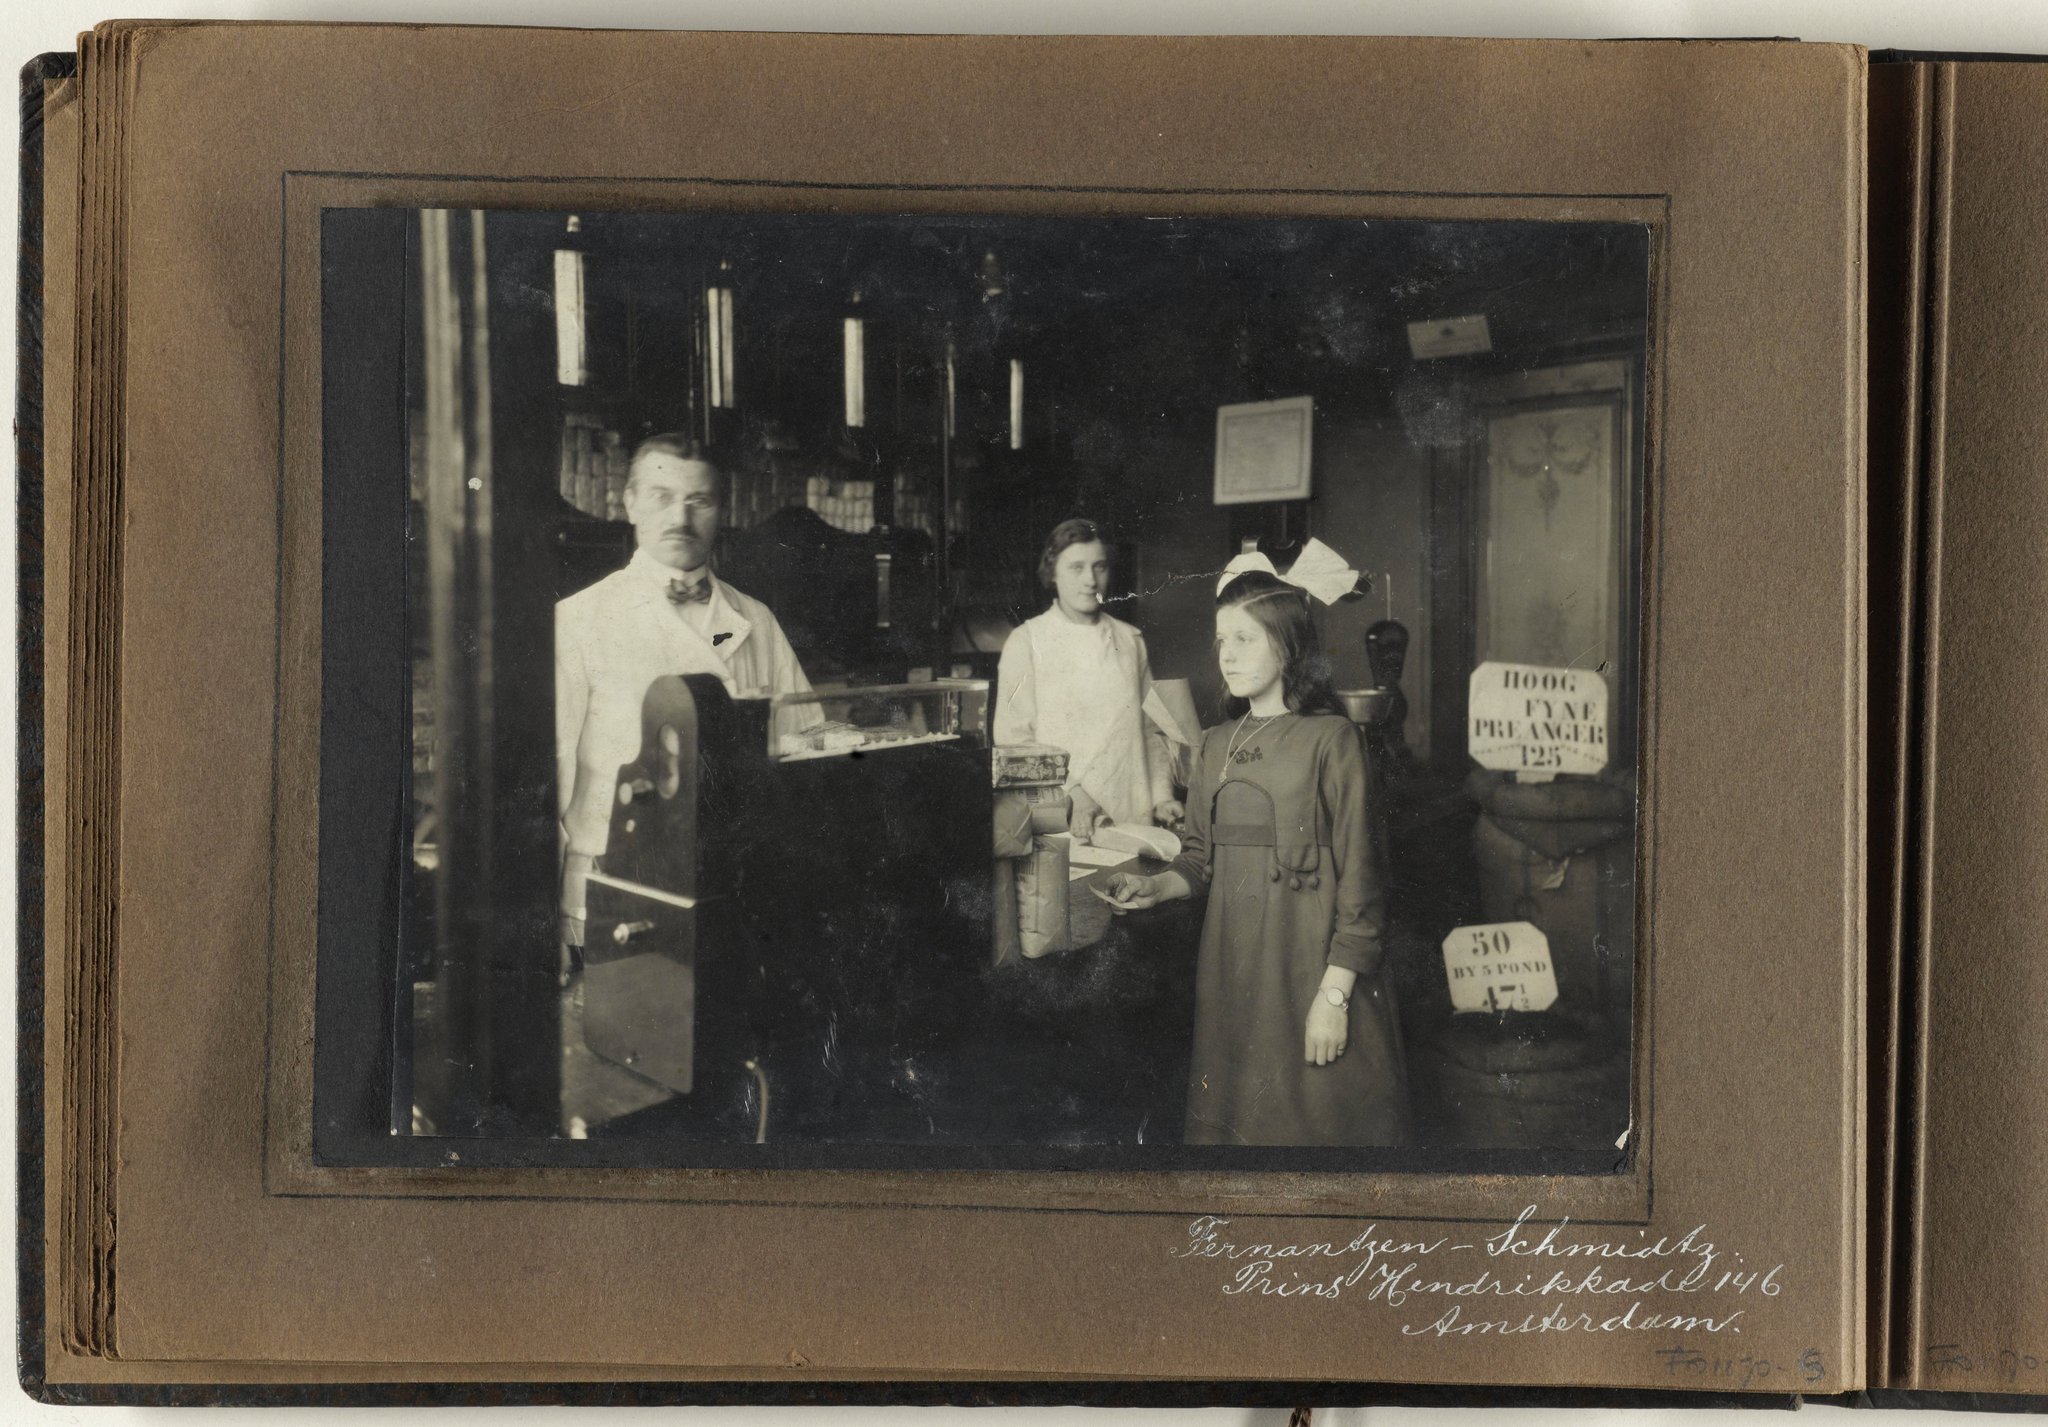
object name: photograph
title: Fernantzen-Schmidtz, Prins Hendrikkade 146, Amsterdam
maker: Anonymous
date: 1925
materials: paper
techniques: gelatin silver print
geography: amsterdam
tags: counter ~ shop, amsterdam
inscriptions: annotation: ‘Fernantzen – Schmidtz/ Prins Hendrikkade 146/ Amsterdam’